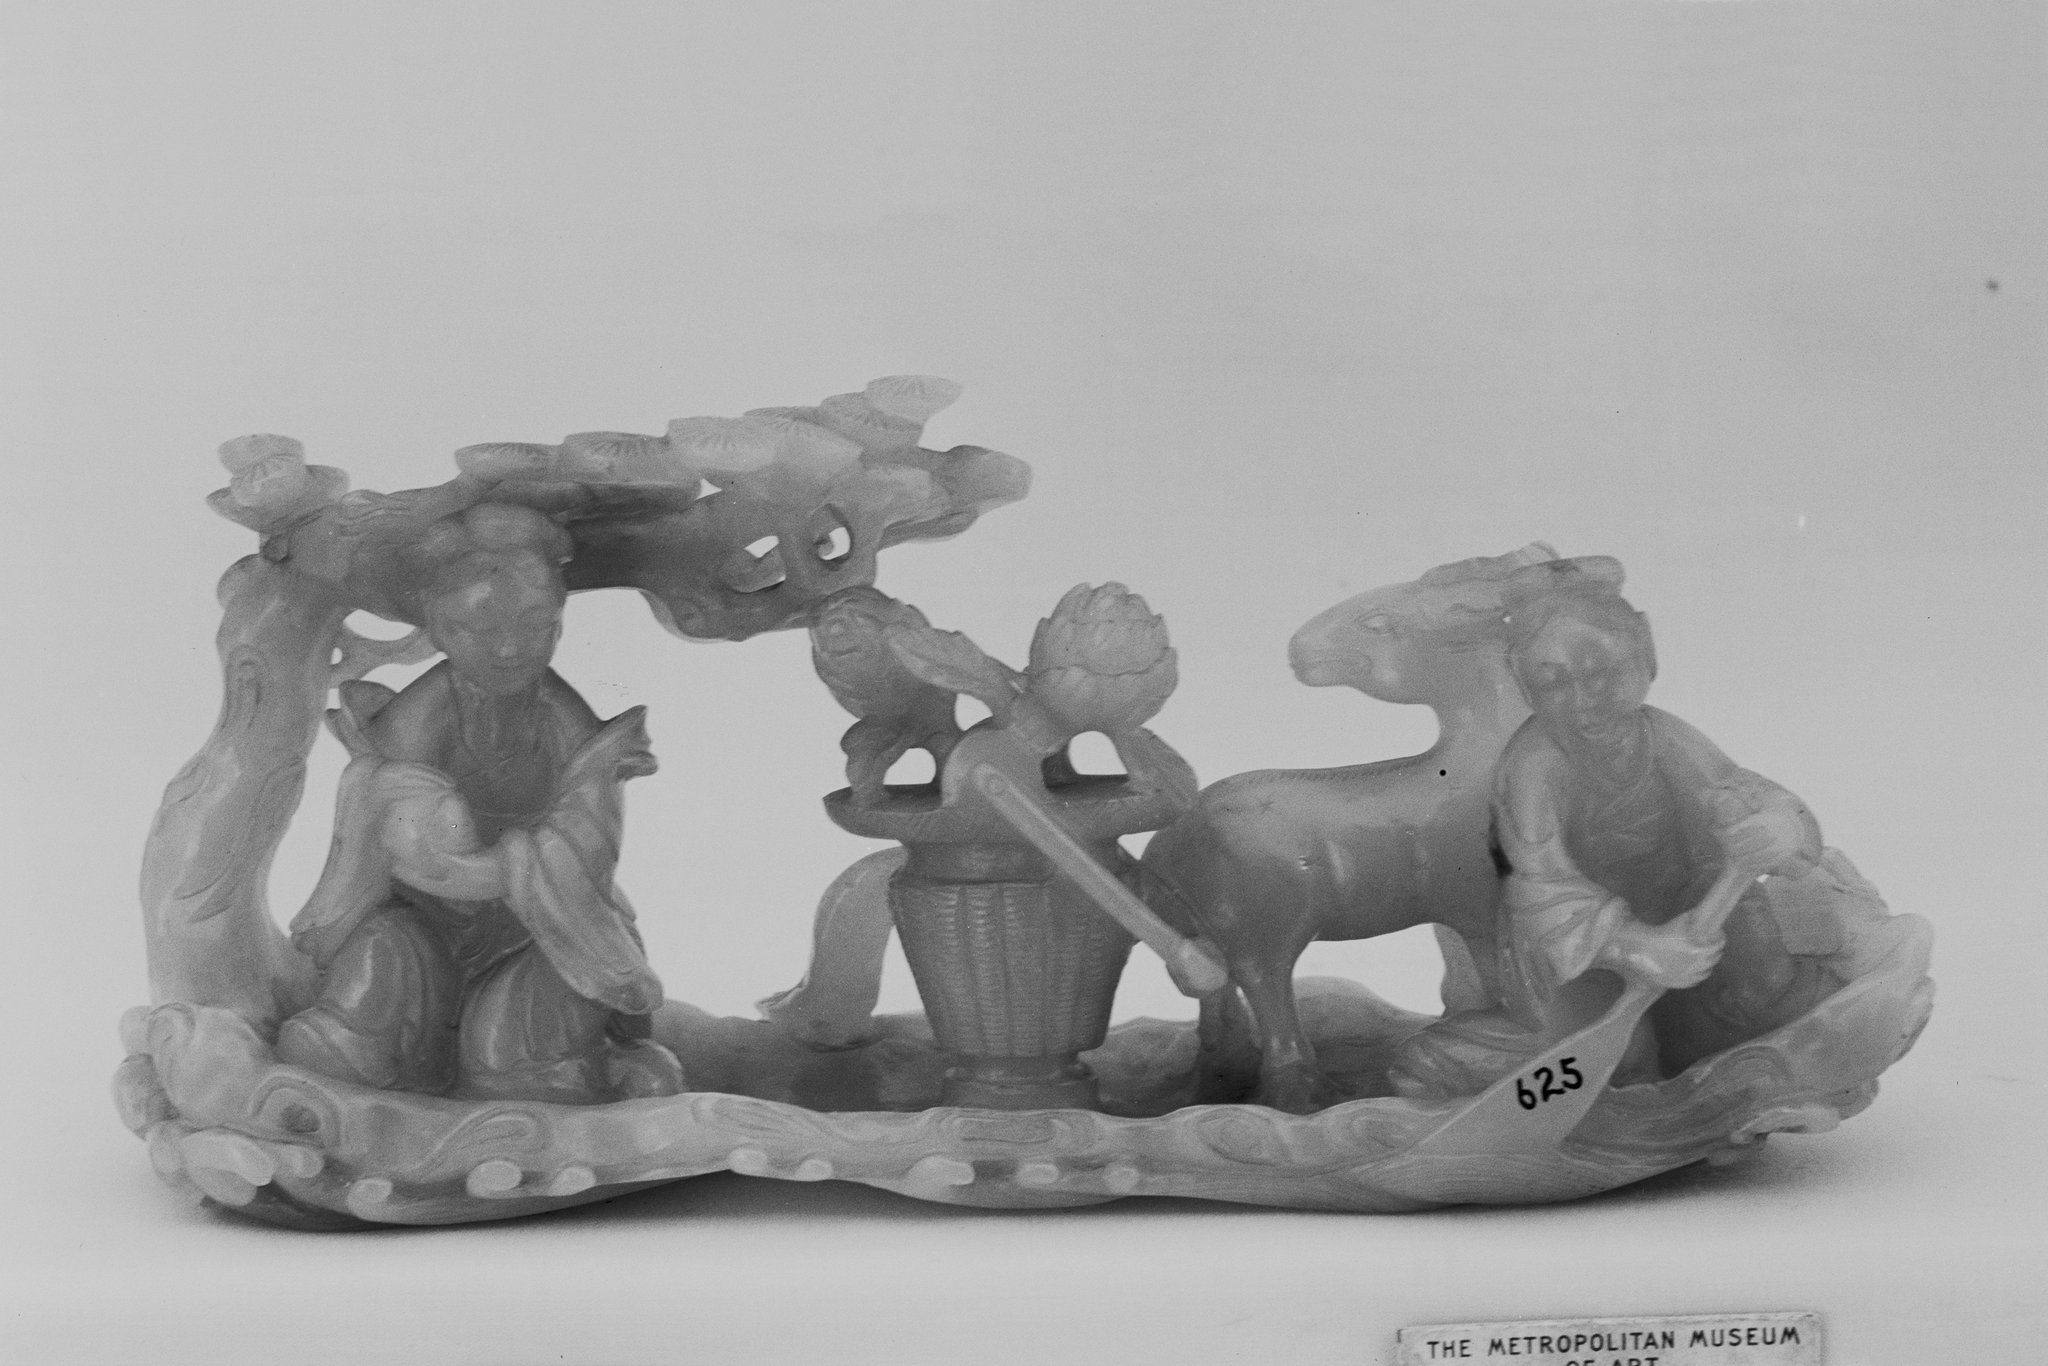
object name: figurine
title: Daoist fairy with attendant on a raft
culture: chinese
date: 1701-1800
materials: jade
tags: human figures,animals,daoism